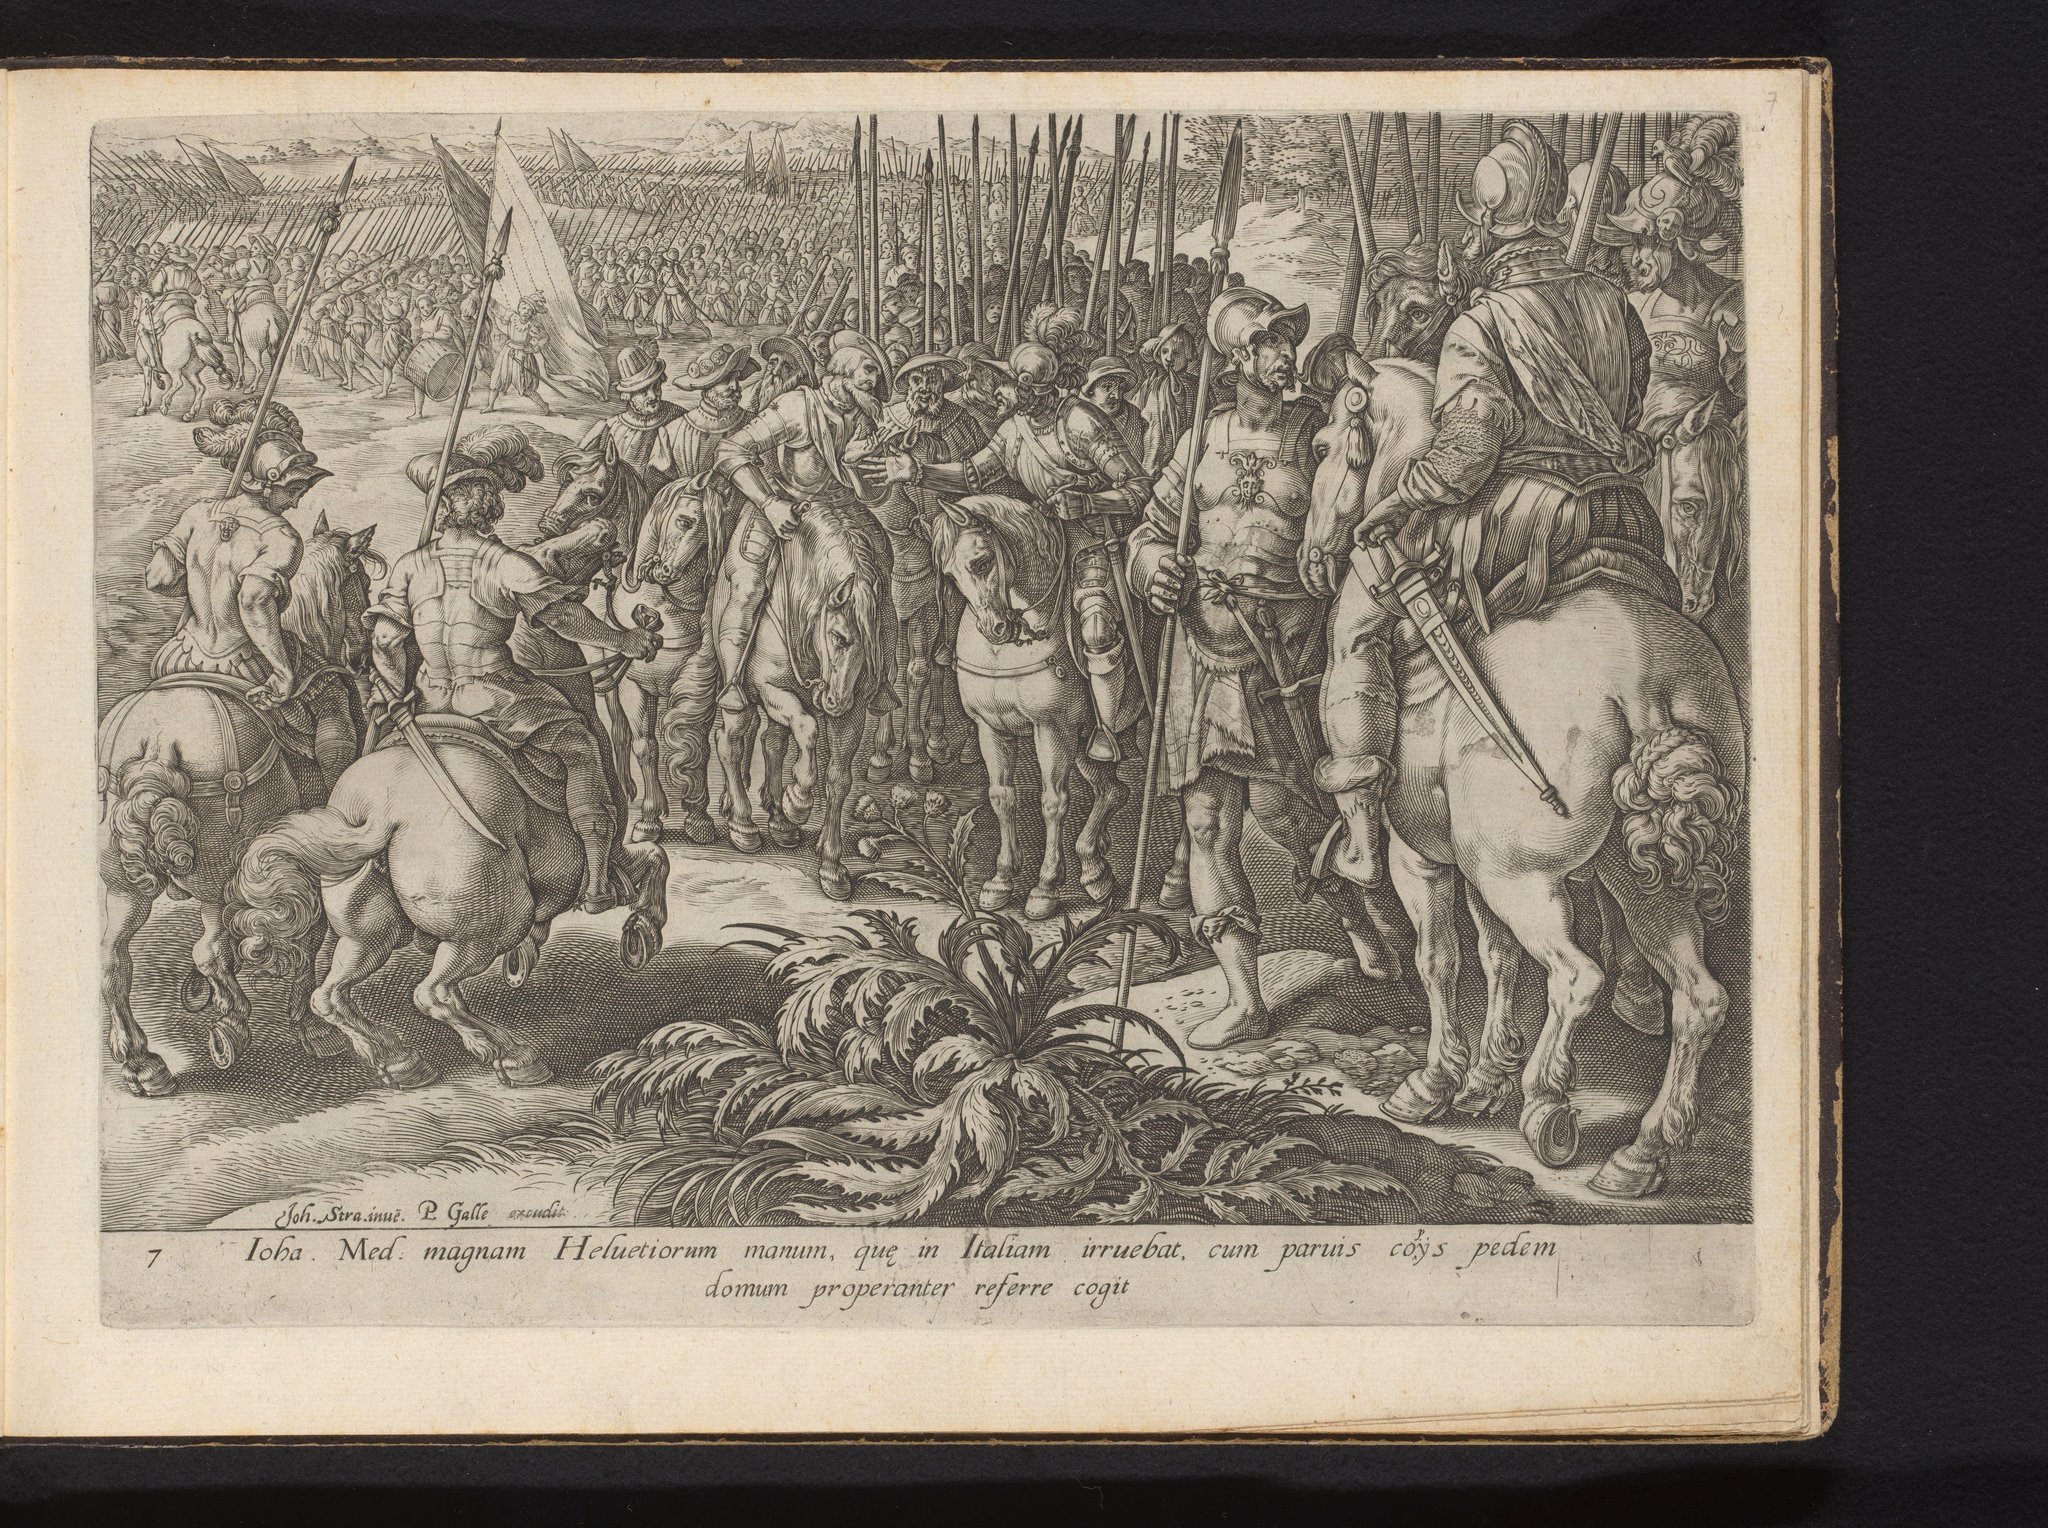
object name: album leaf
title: Mediceae Familiae rerum feliciter gestarum victoriae et triumphi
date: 1583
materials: paper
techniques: engraving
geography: florence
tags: preparation for battle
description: Giovanni de' Medici, bijgenaamd 'dalle Bande Nere', in overleg met Zwitserse landsknechten. In de ondermarge twee regels tekst in het Latijn en genummerd 7. De prent maakt deel uit van een album.